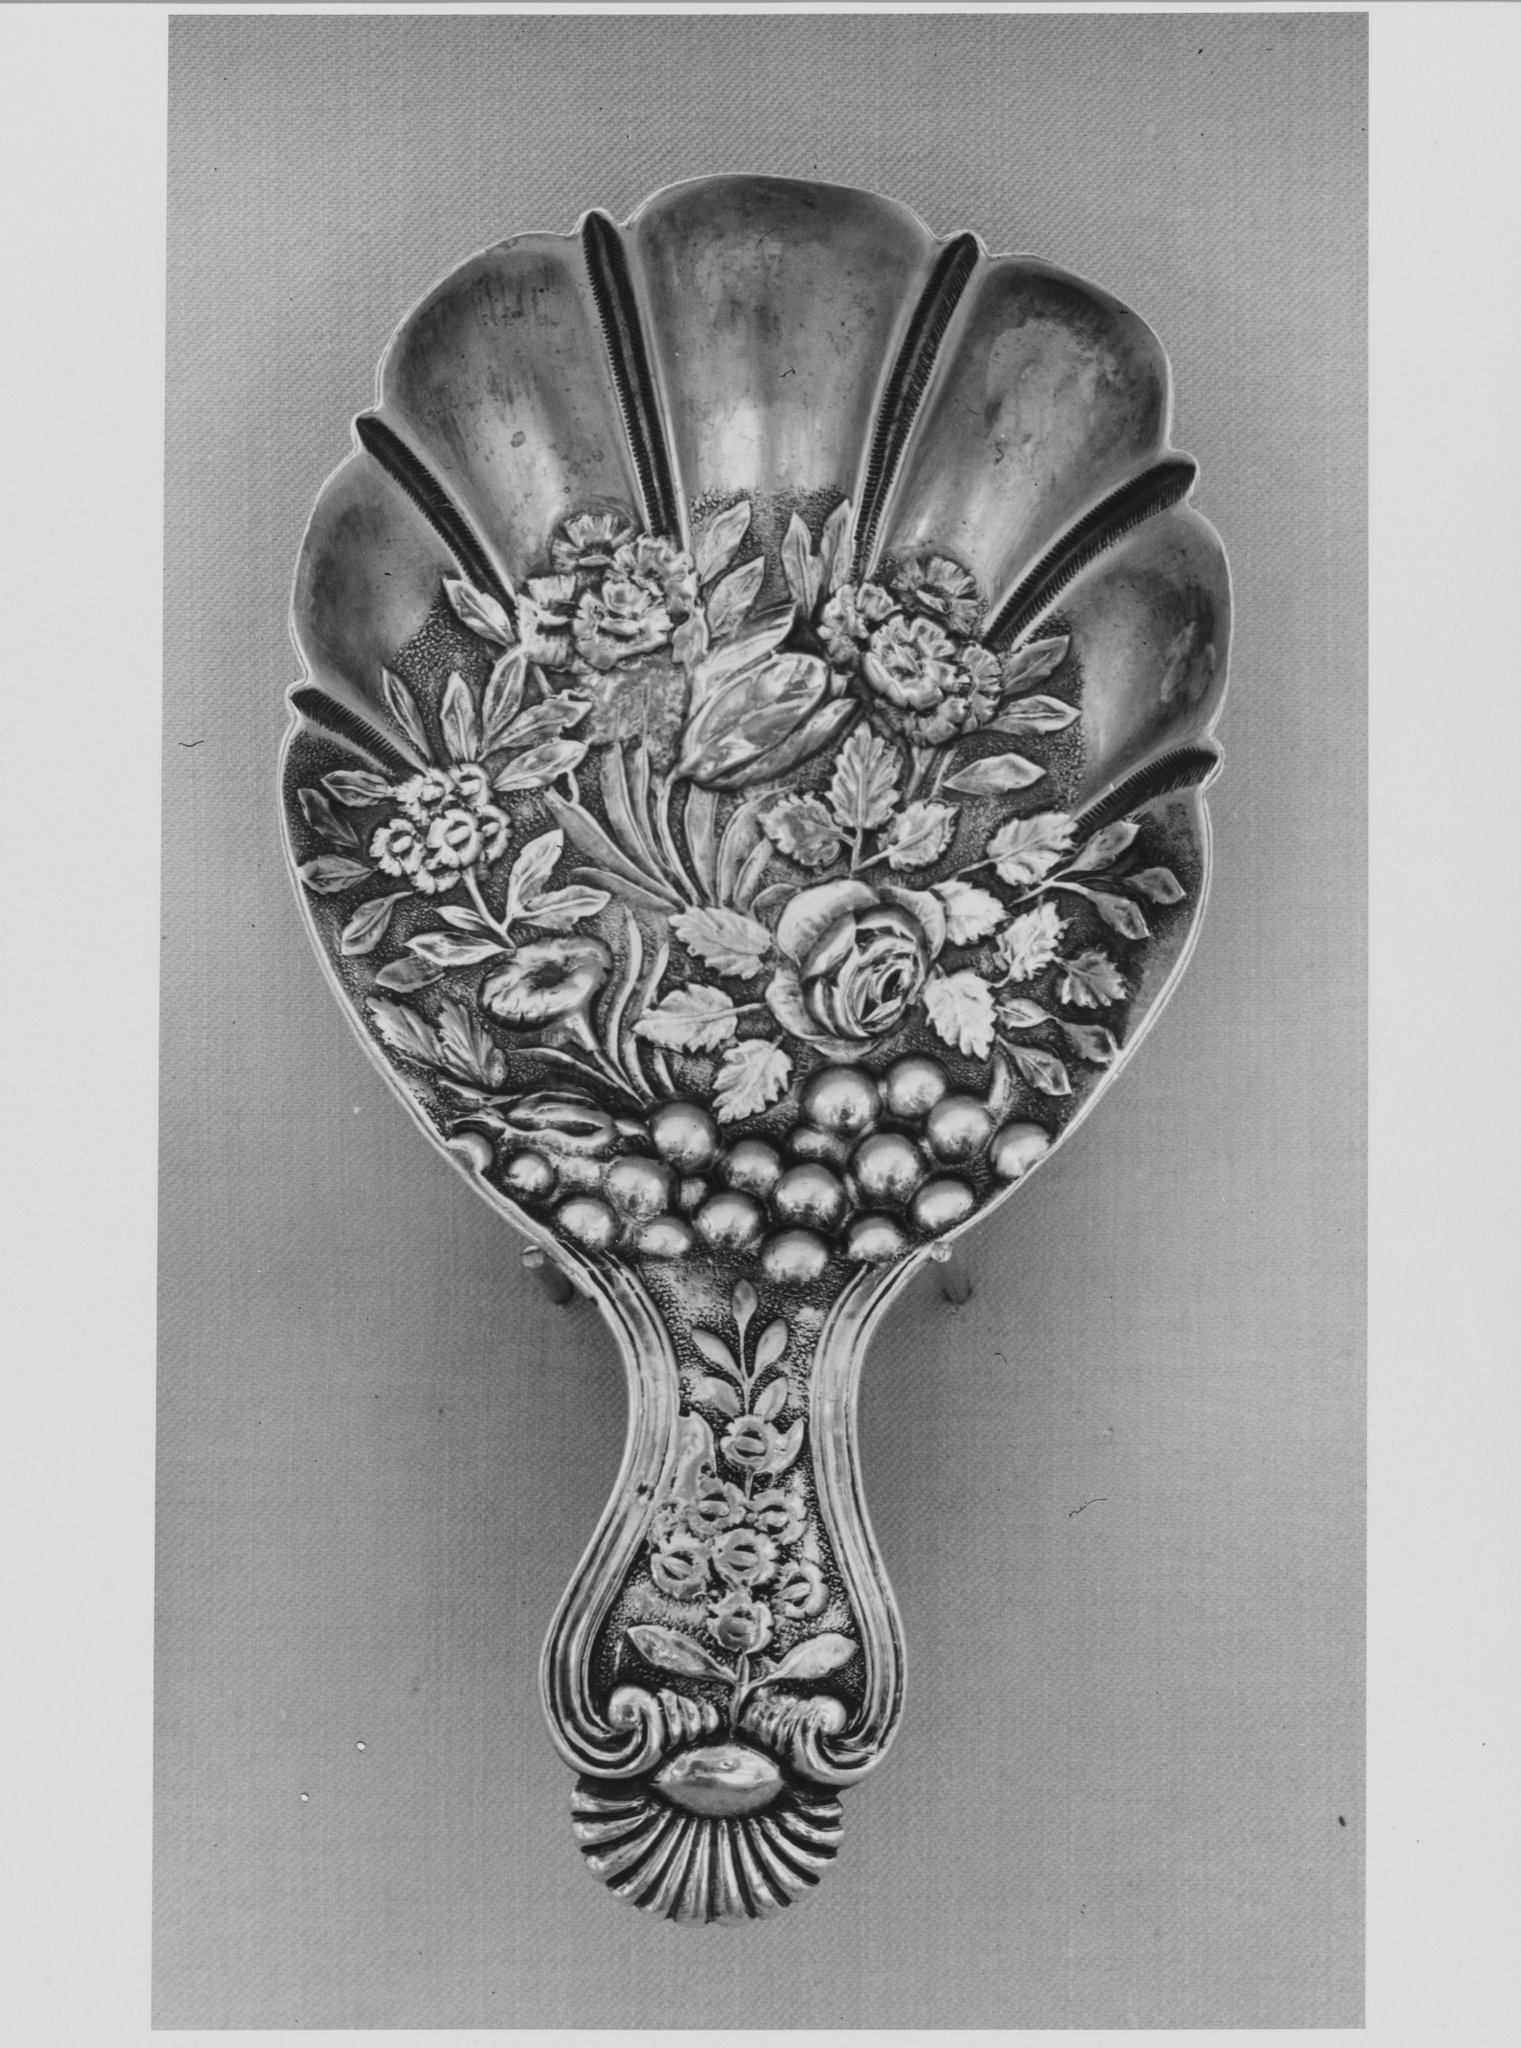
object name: tea caddy with spoon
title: Tea caddy spoon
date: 1790-1791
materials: silver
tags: flowers